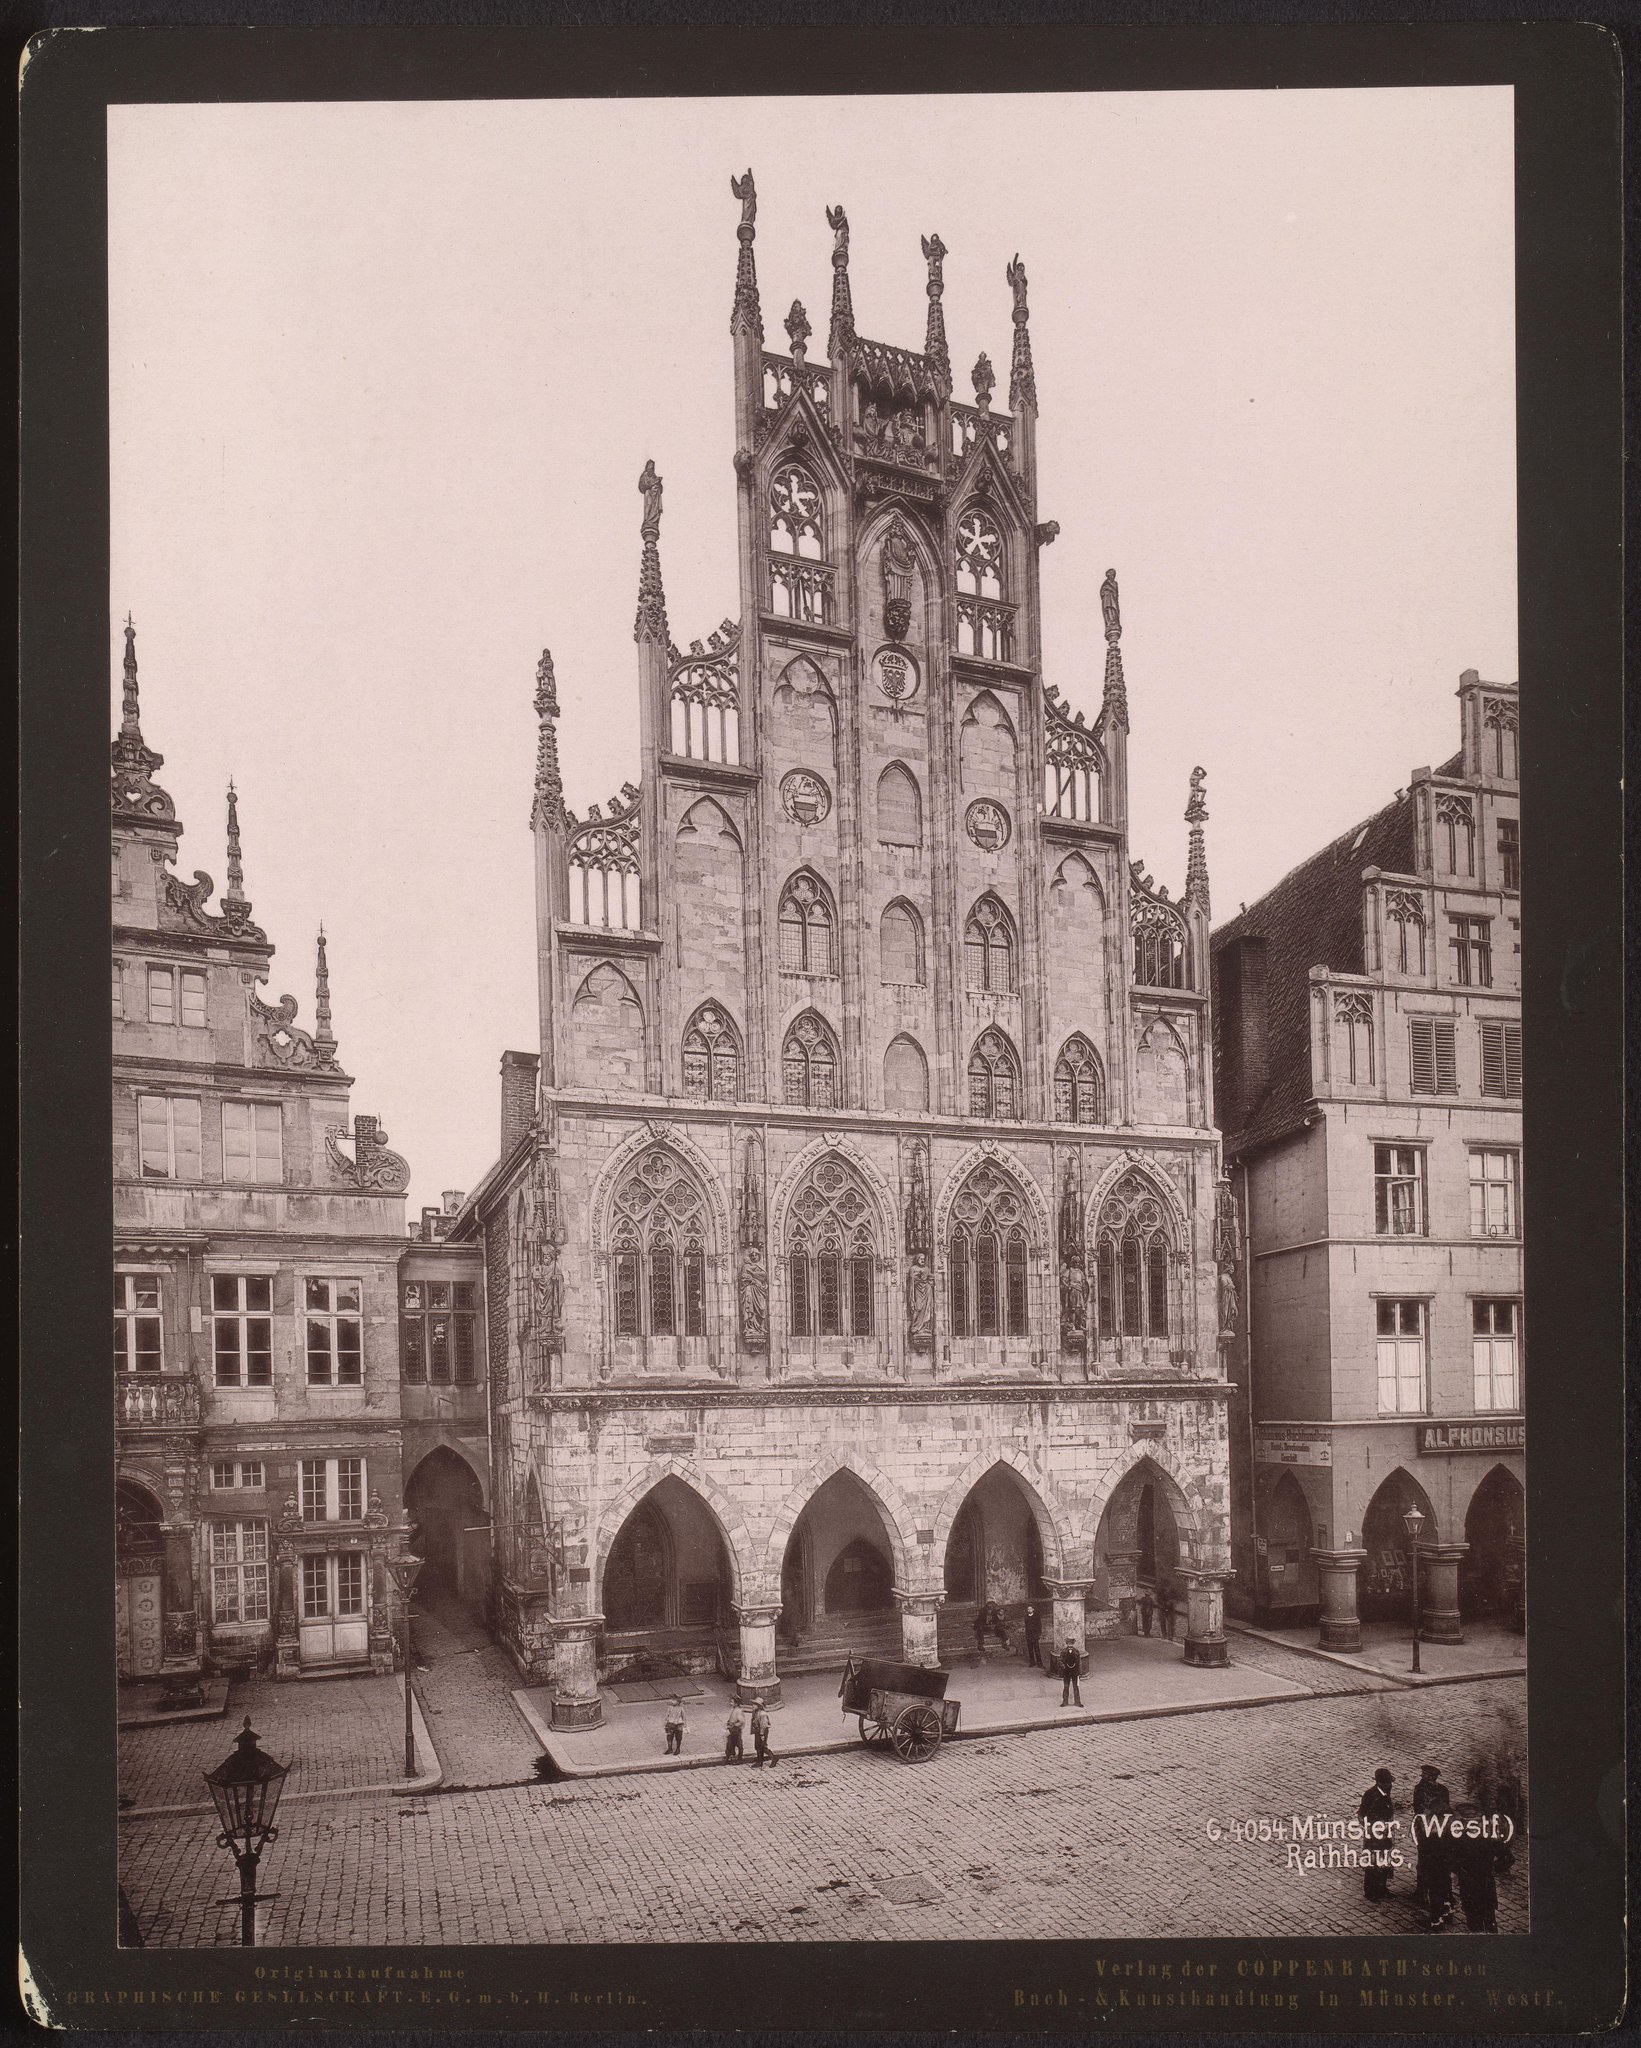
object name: photomechanical print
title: Münster (Westf.) Rathhaus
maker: Anonymous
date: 1897-1910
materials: cardboard, paper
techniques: photograph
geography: munster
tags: townhall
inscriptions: number: ‘23217/ 3/4’, inscription: ‘G. 4054 Münster. (Westf.)/ Rathhaus’